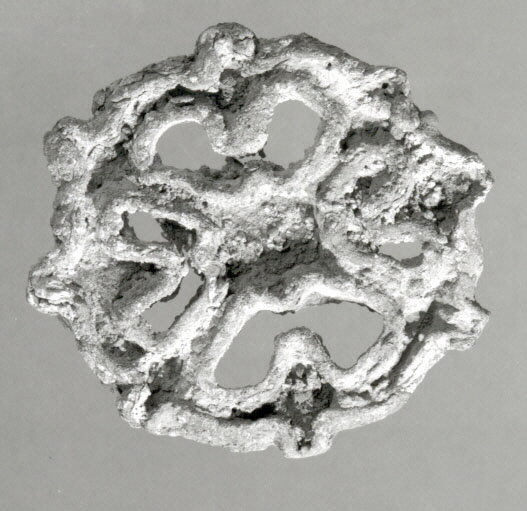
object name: stamp seal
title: Compartmented stamp seal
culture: bactria-margiana archaeological complex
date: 2333-1668 BCE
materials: copper alloy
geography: bactria-margiana